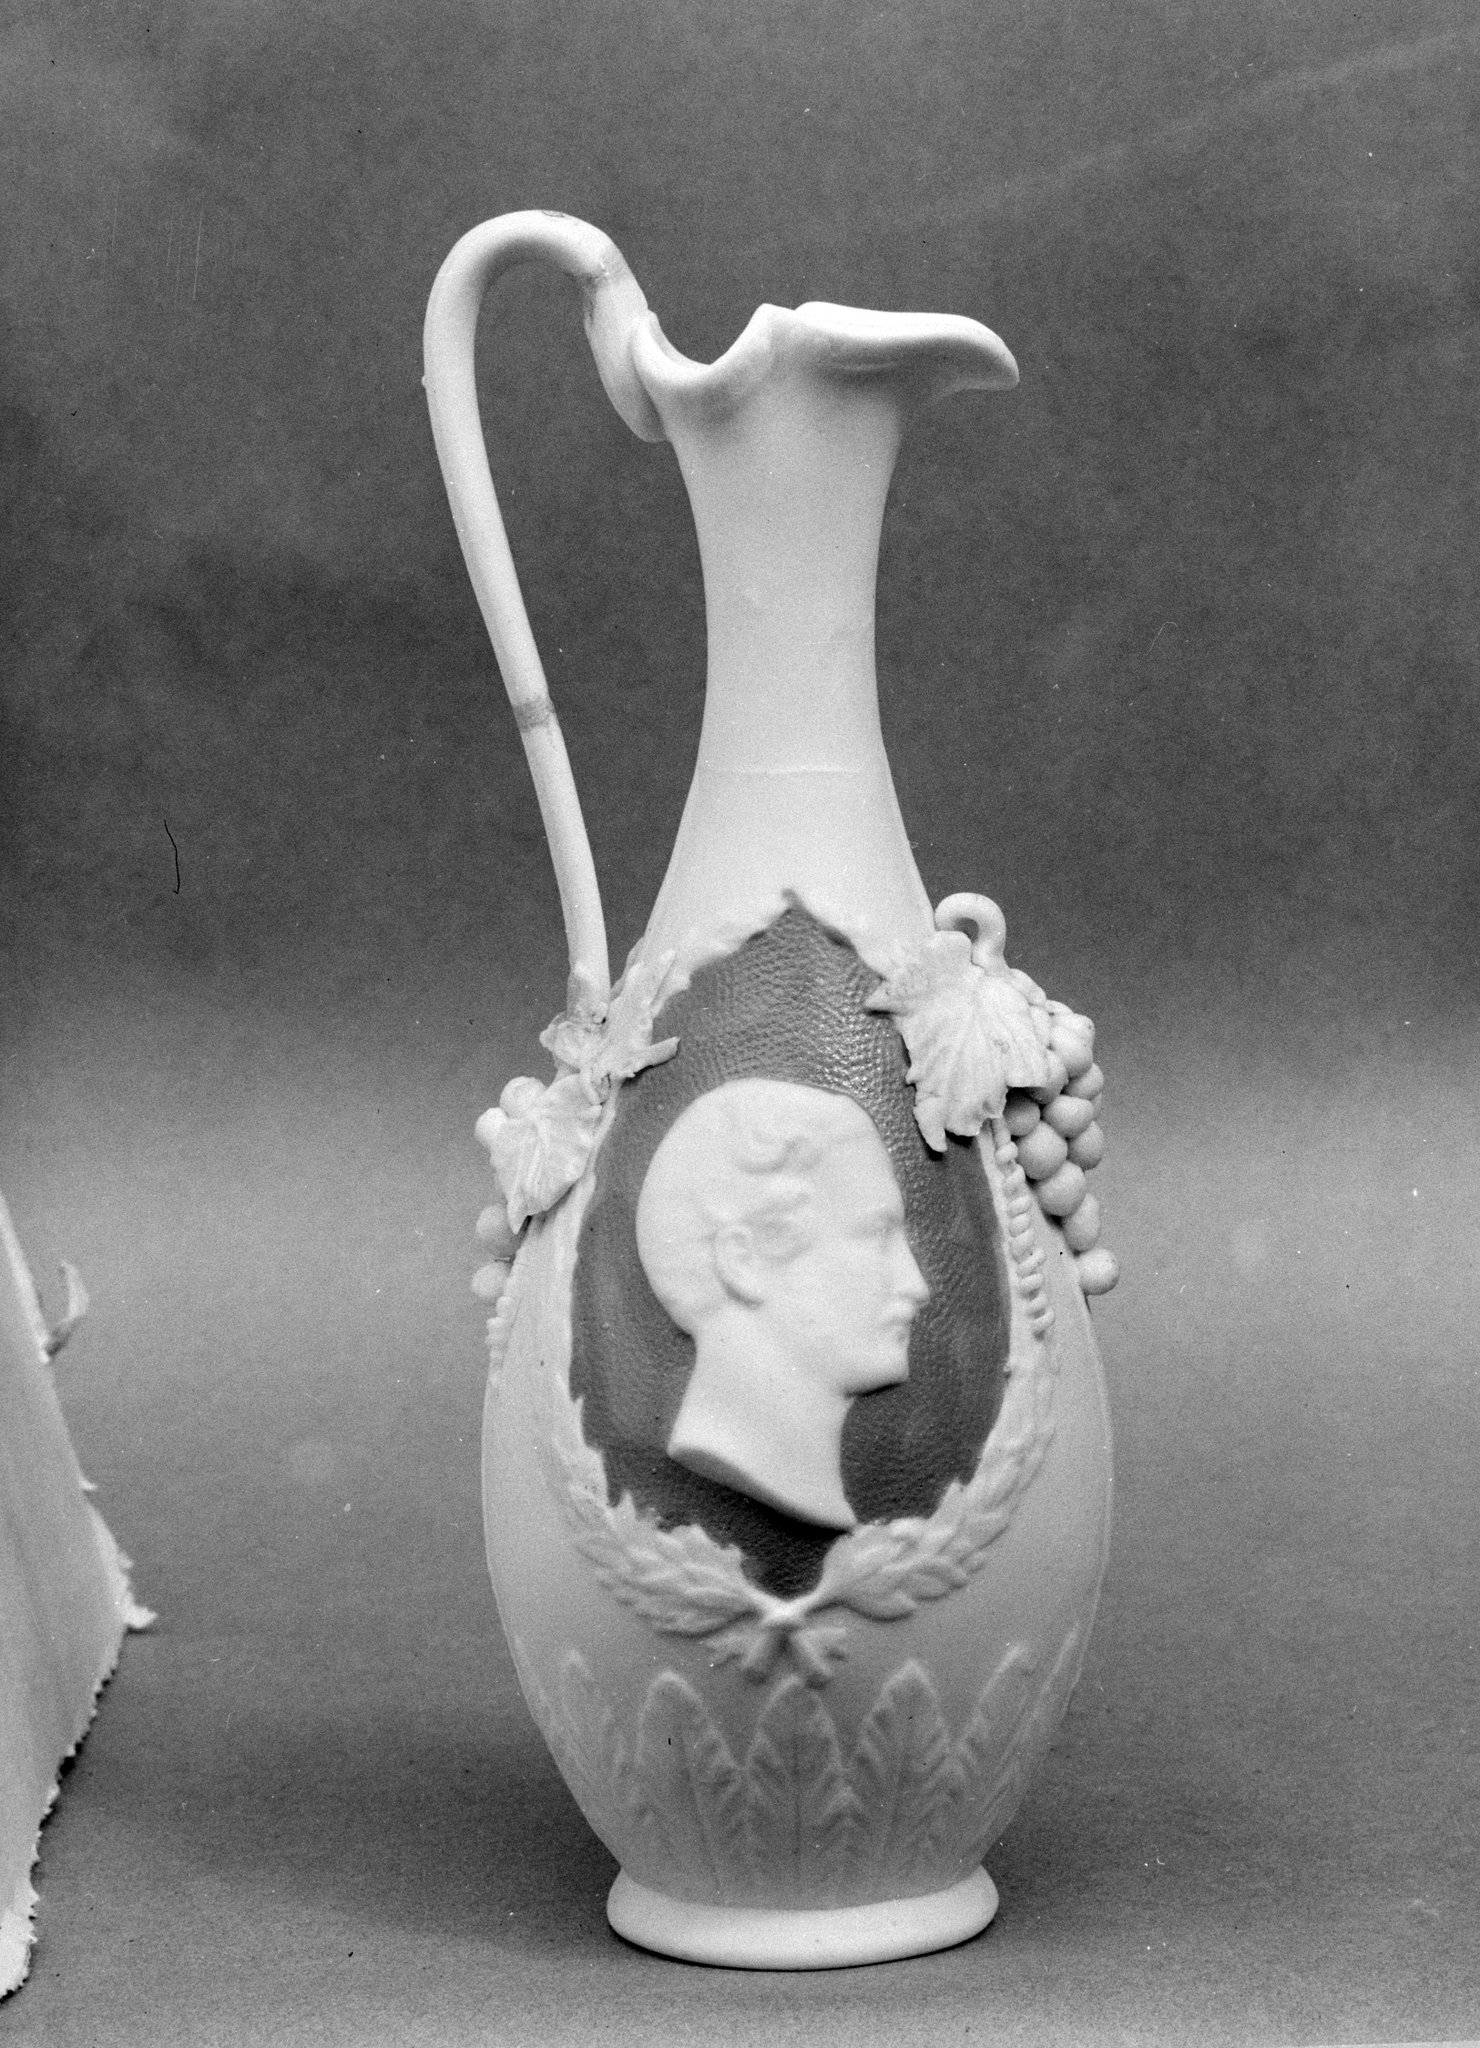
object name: ewer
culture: american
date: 1830-1870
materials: porcelain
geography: united states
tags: grapes,men,profiles